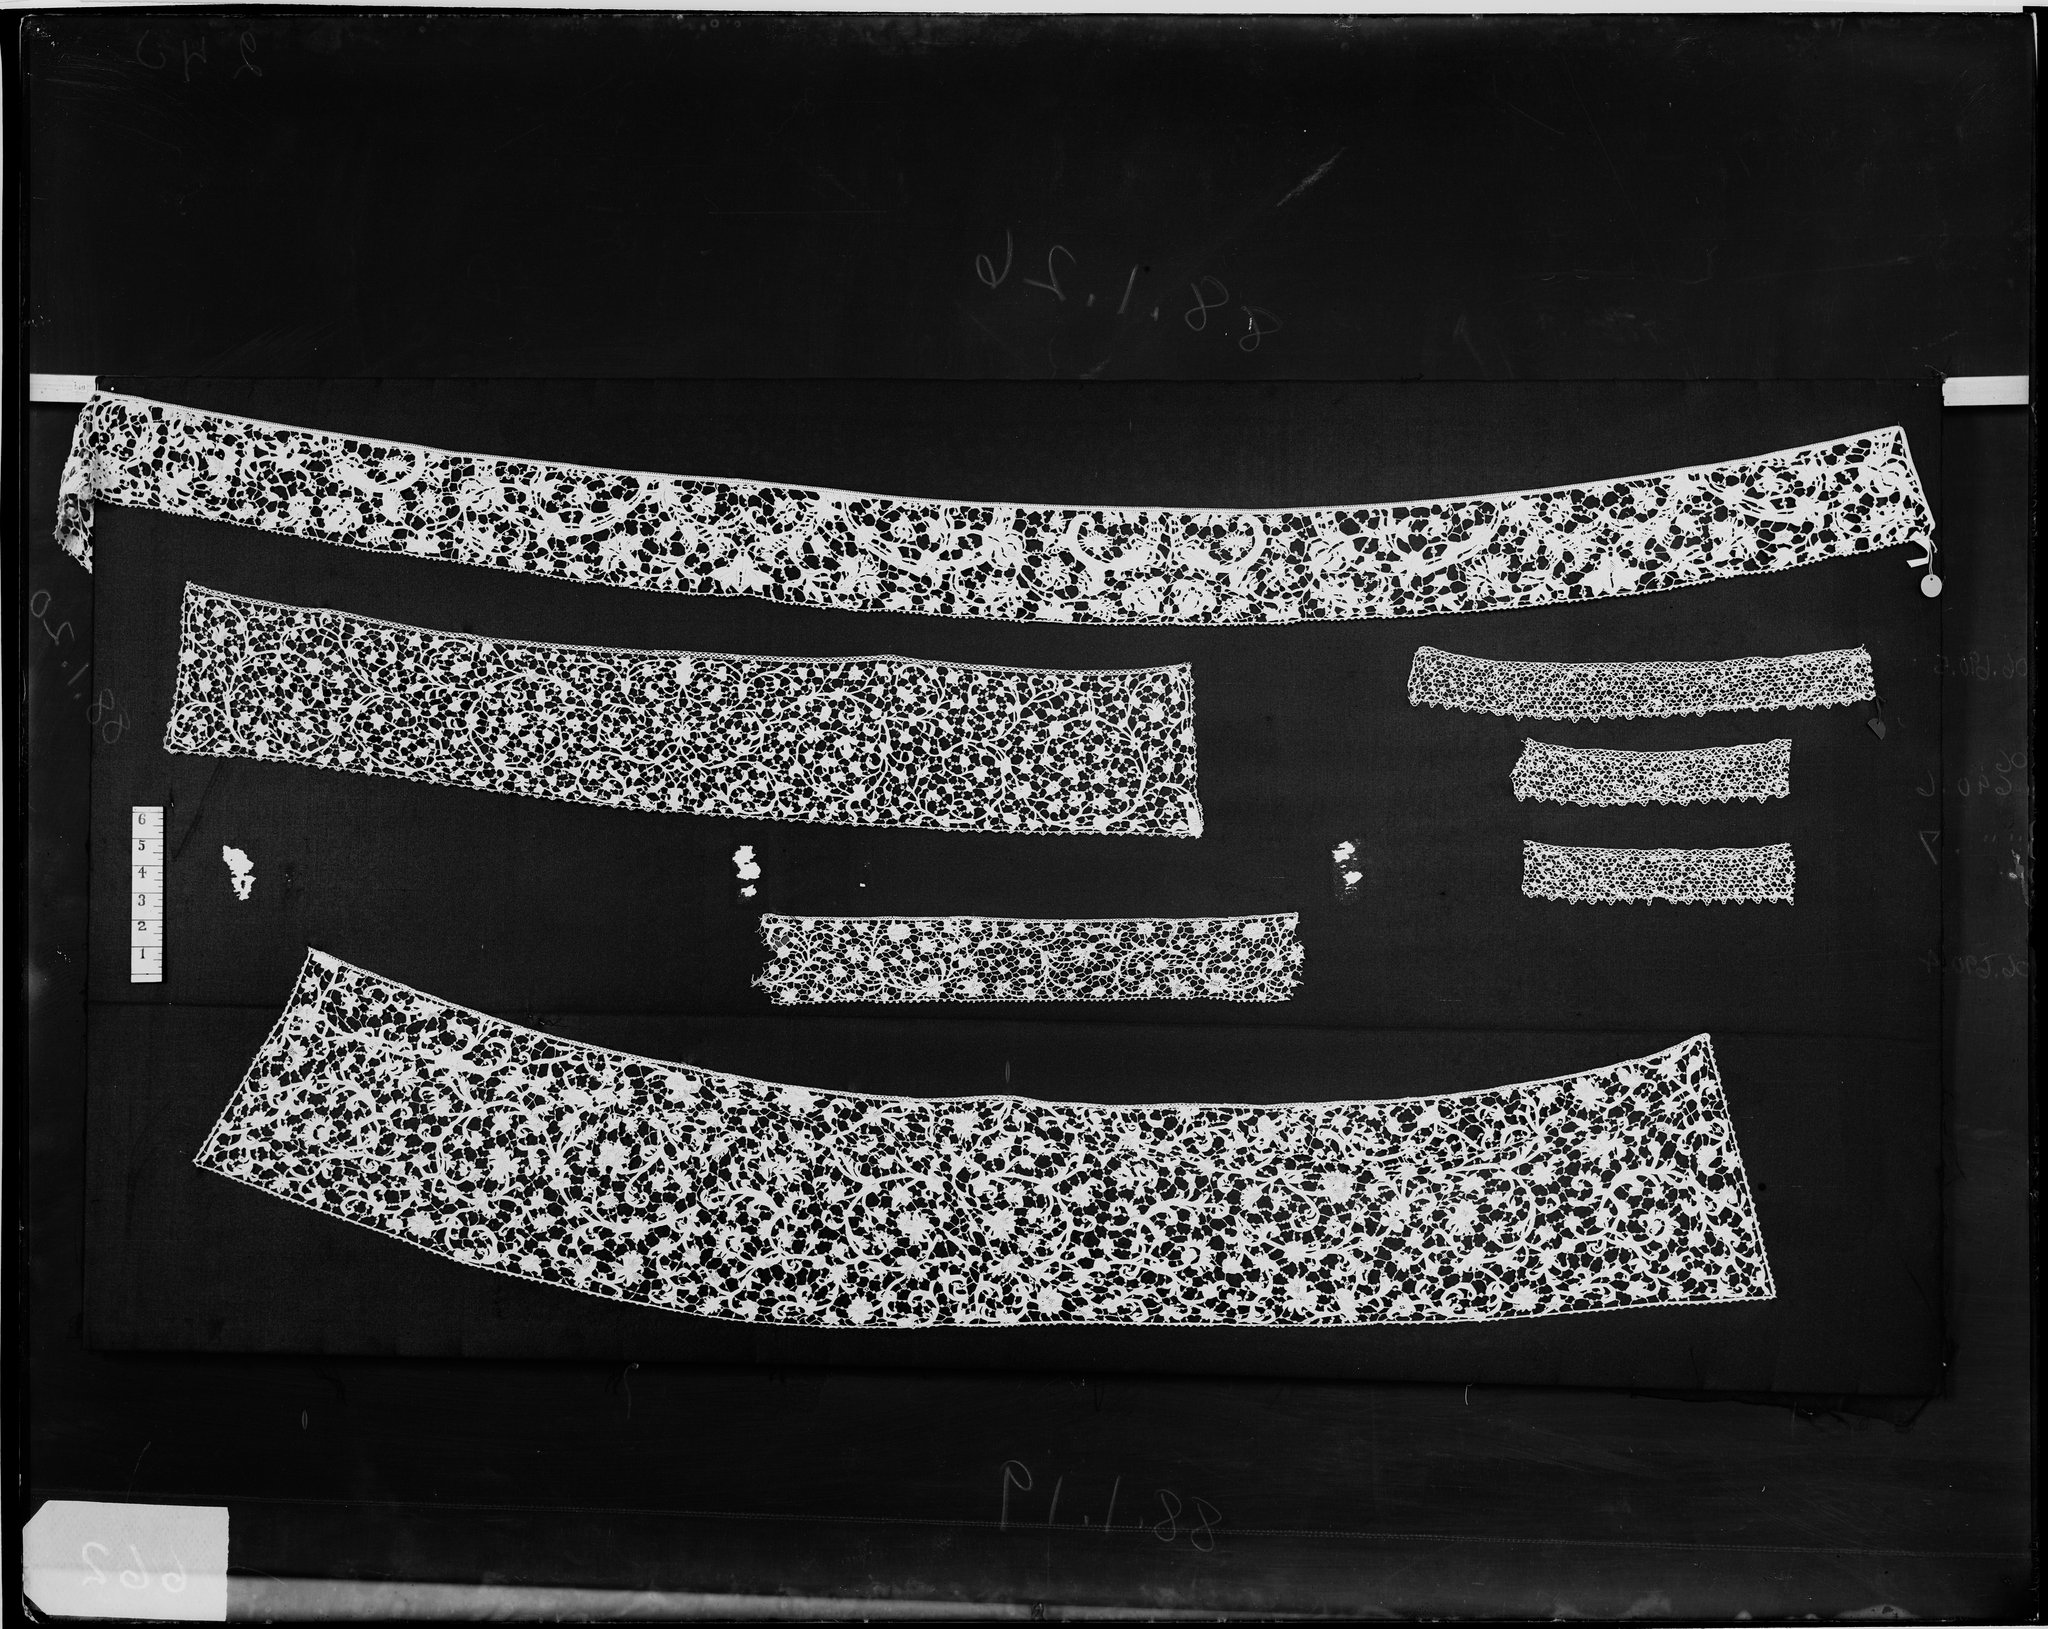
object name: fragment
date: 1667-1700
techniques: lace